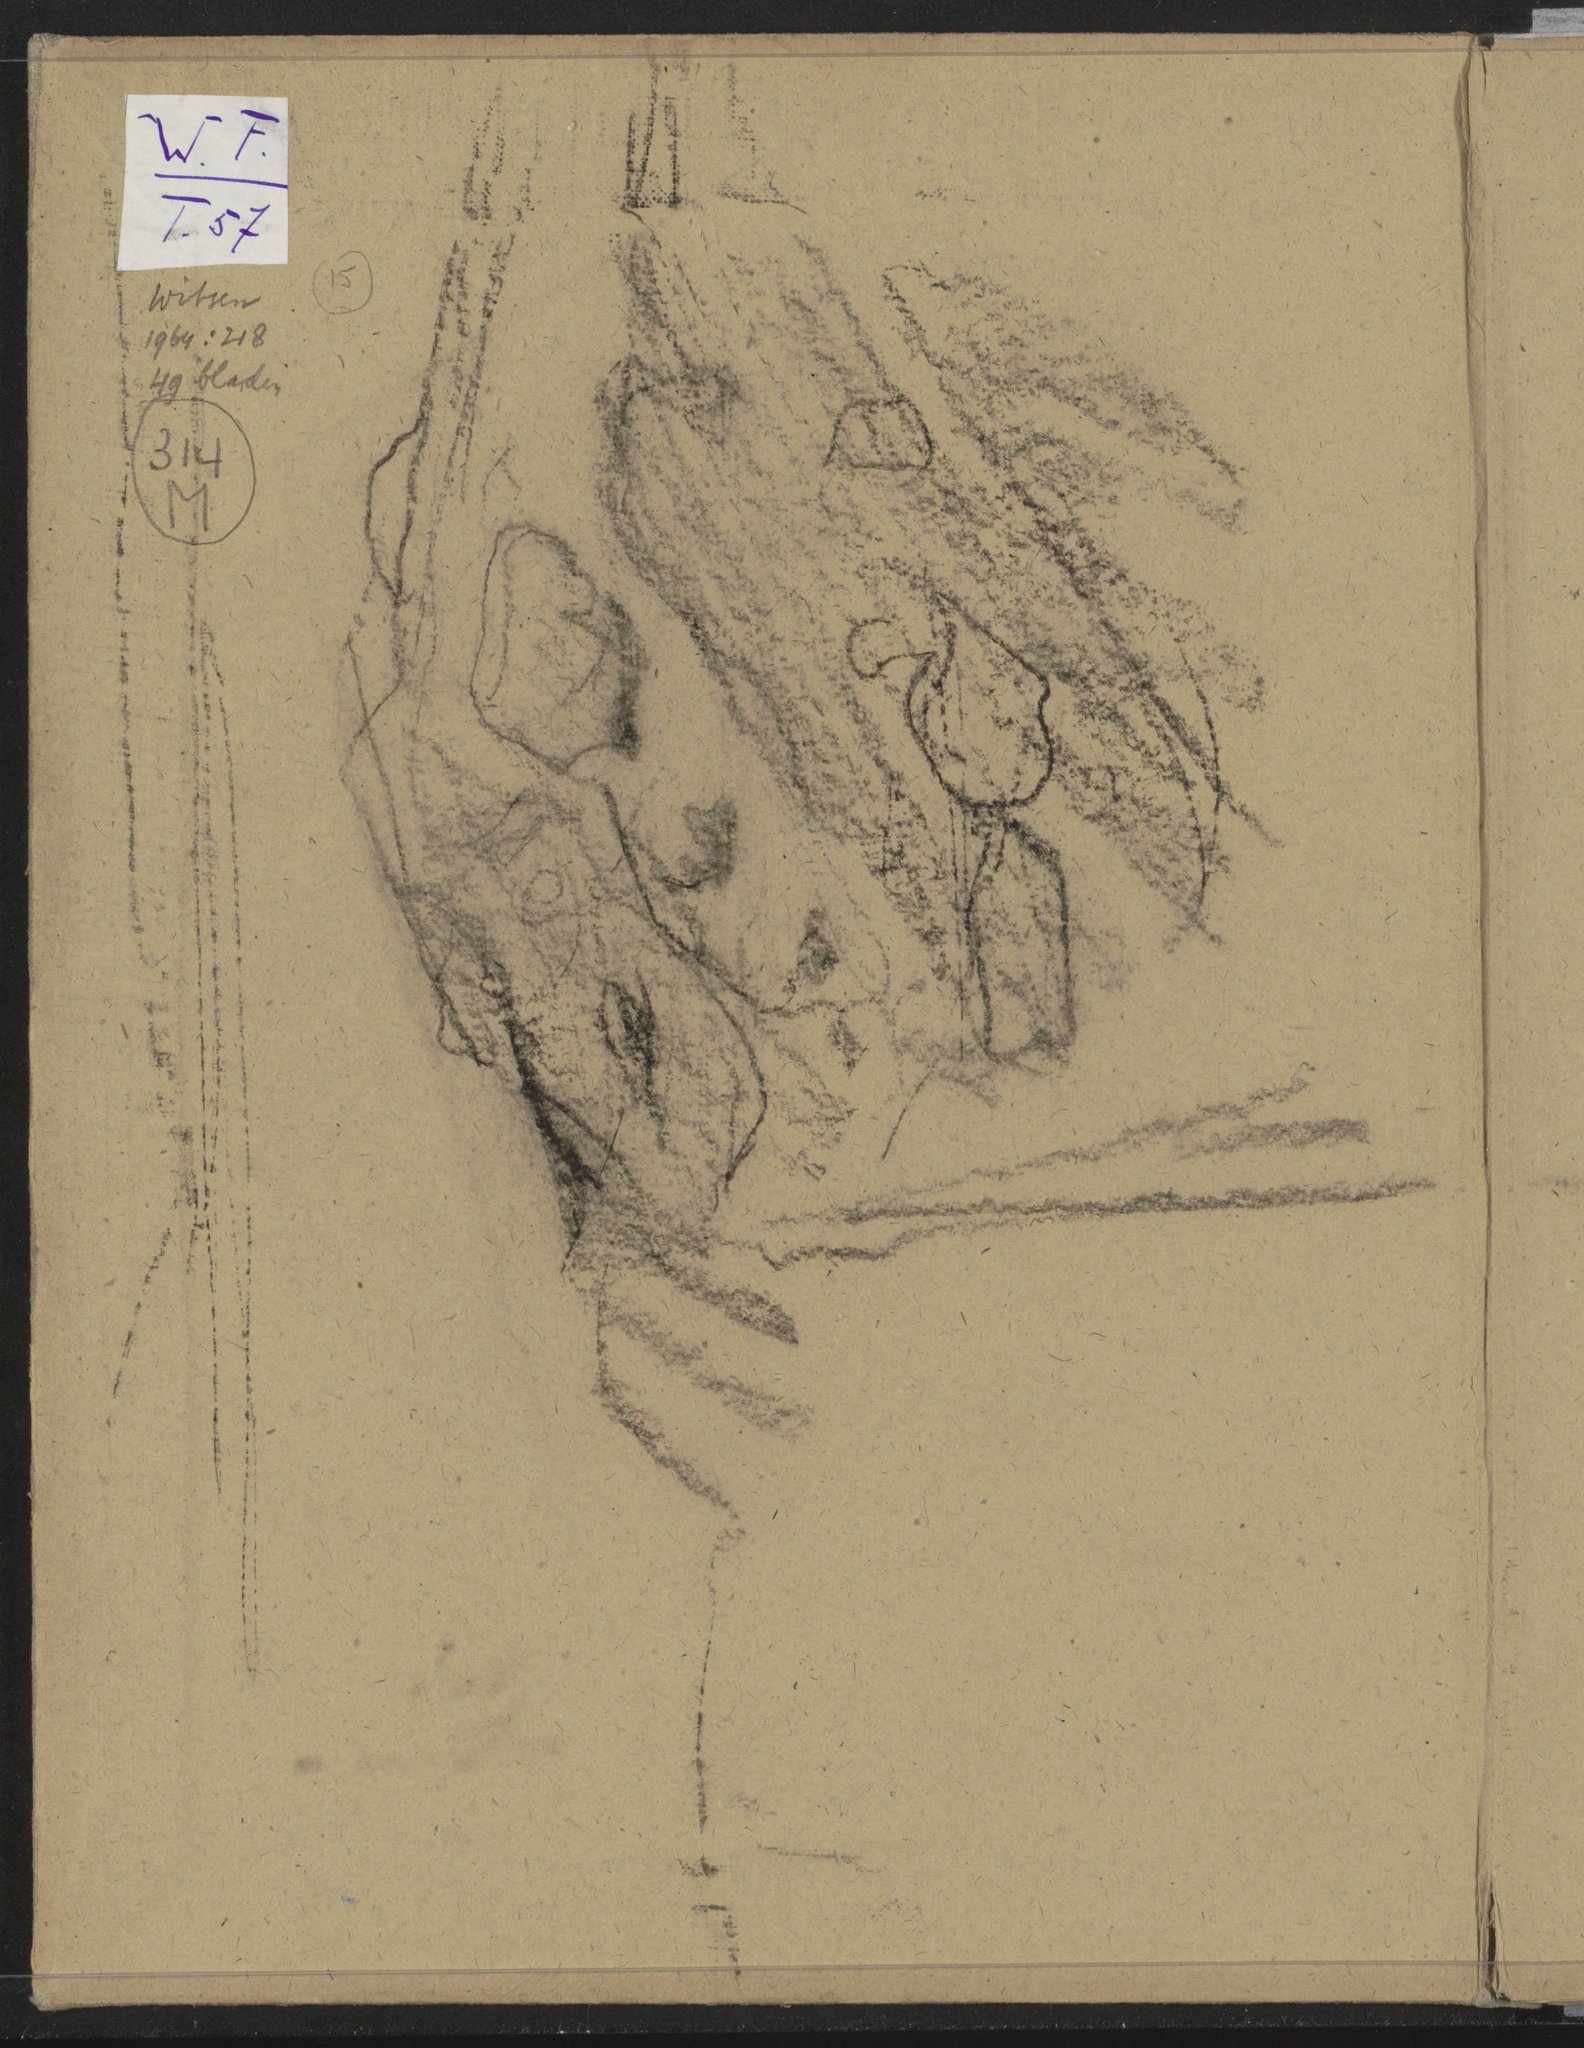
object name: sketchbook leaf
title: Studie, mogelijk van een landschap met wolkenlucht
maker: willem witsen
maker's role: draughtsman, painter, print maker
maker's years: 1860-1923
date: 1884-1887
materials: chalk, paper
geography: ewijkshoeve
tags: landscapes, clouds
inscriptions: annotation: ‘W.F./ T. 57’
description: Schutblad A, voorste schutblad, uit een schetsboek met 49 bladen.